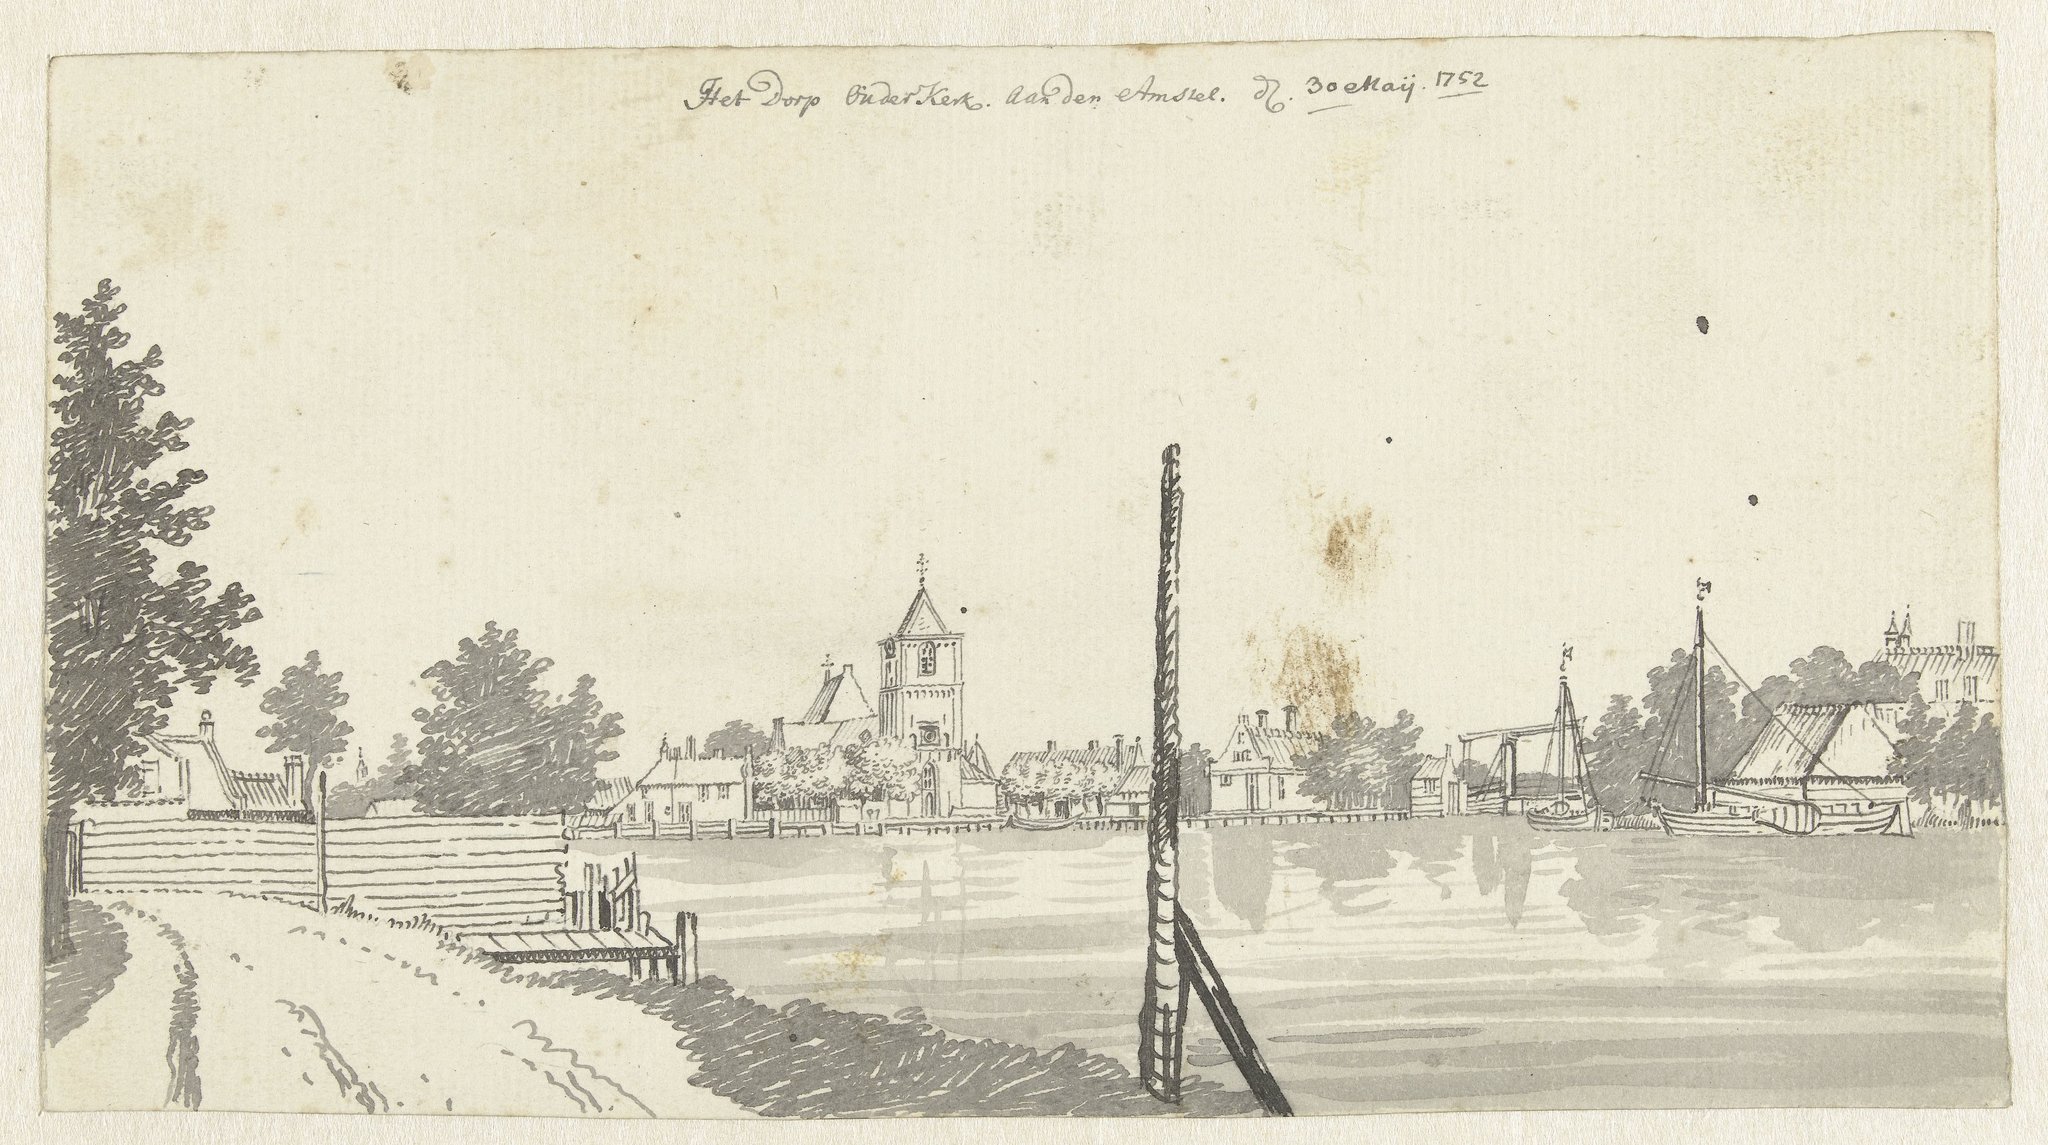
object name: drawing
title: Het dorp Ouderkerk aan de Amstel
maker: jan de beijer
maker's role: draughtsman, print maker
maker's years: 1703-1780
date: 1752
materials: ink, paper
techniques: brush, pen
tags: prospect of city, town panorama, silhouette of city